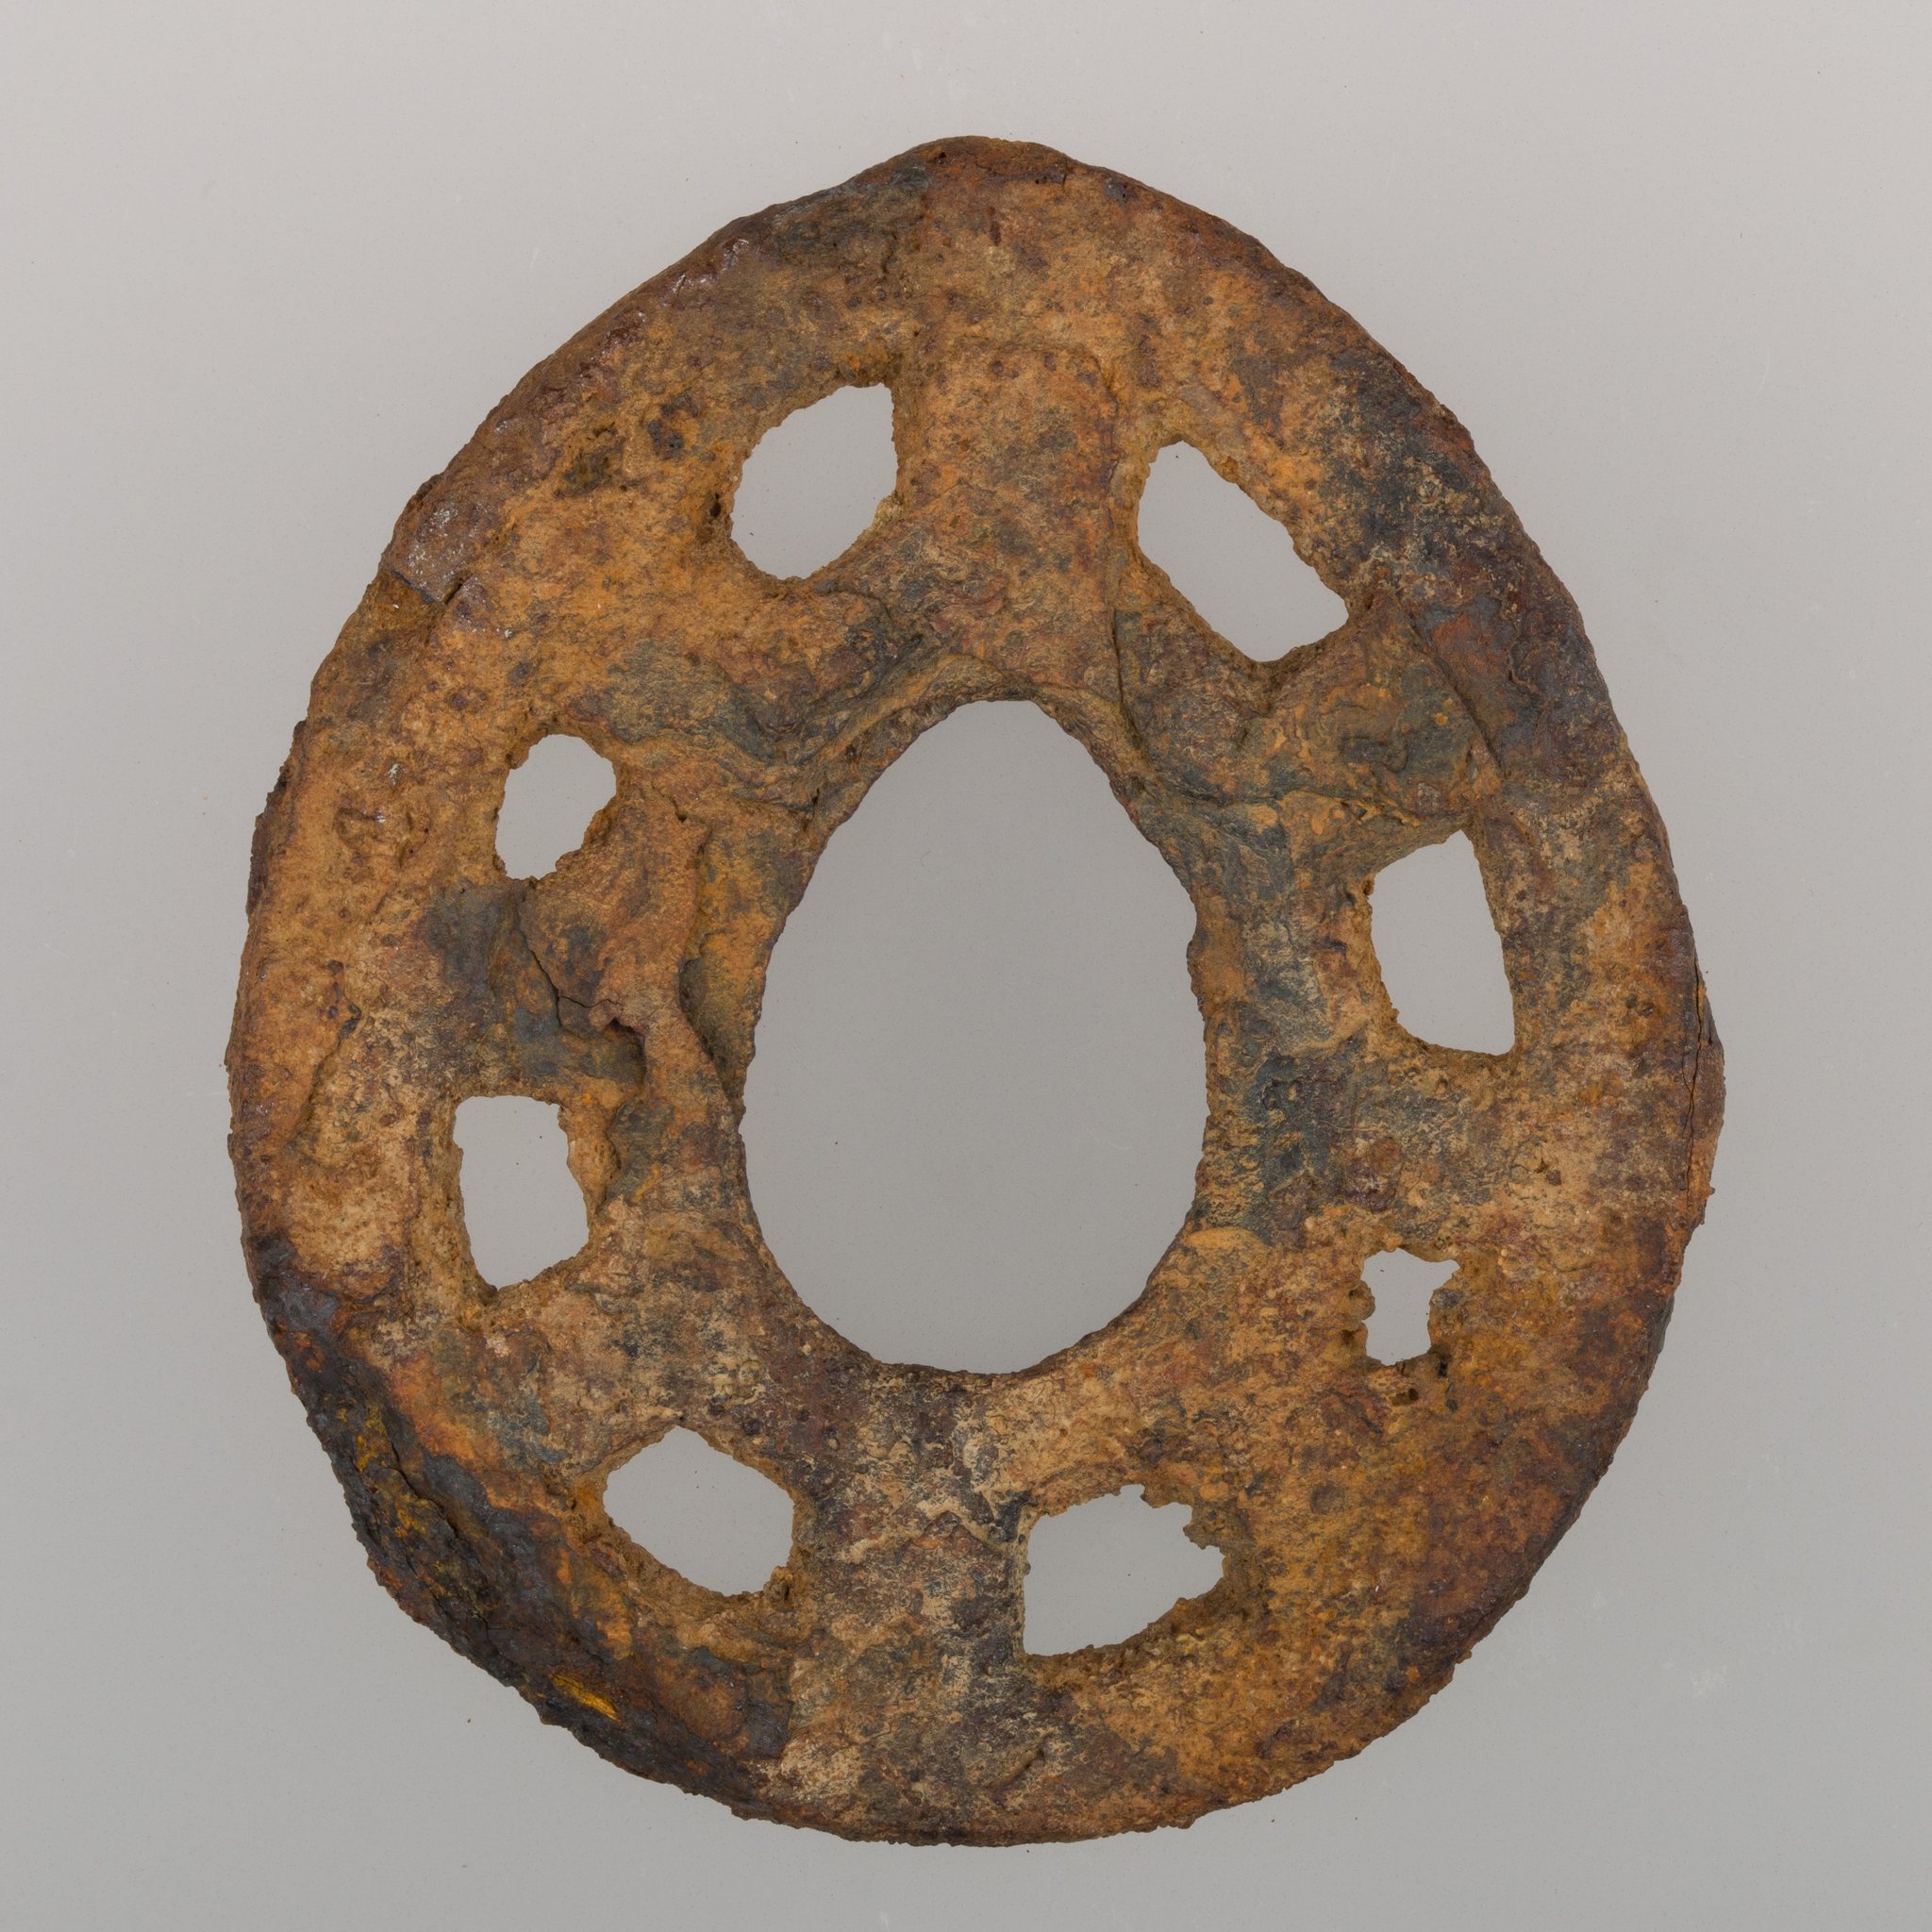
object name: sword guard tsuba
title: Sword Guard (Tsuba)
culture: japanese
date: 201-300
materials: iron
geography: japan